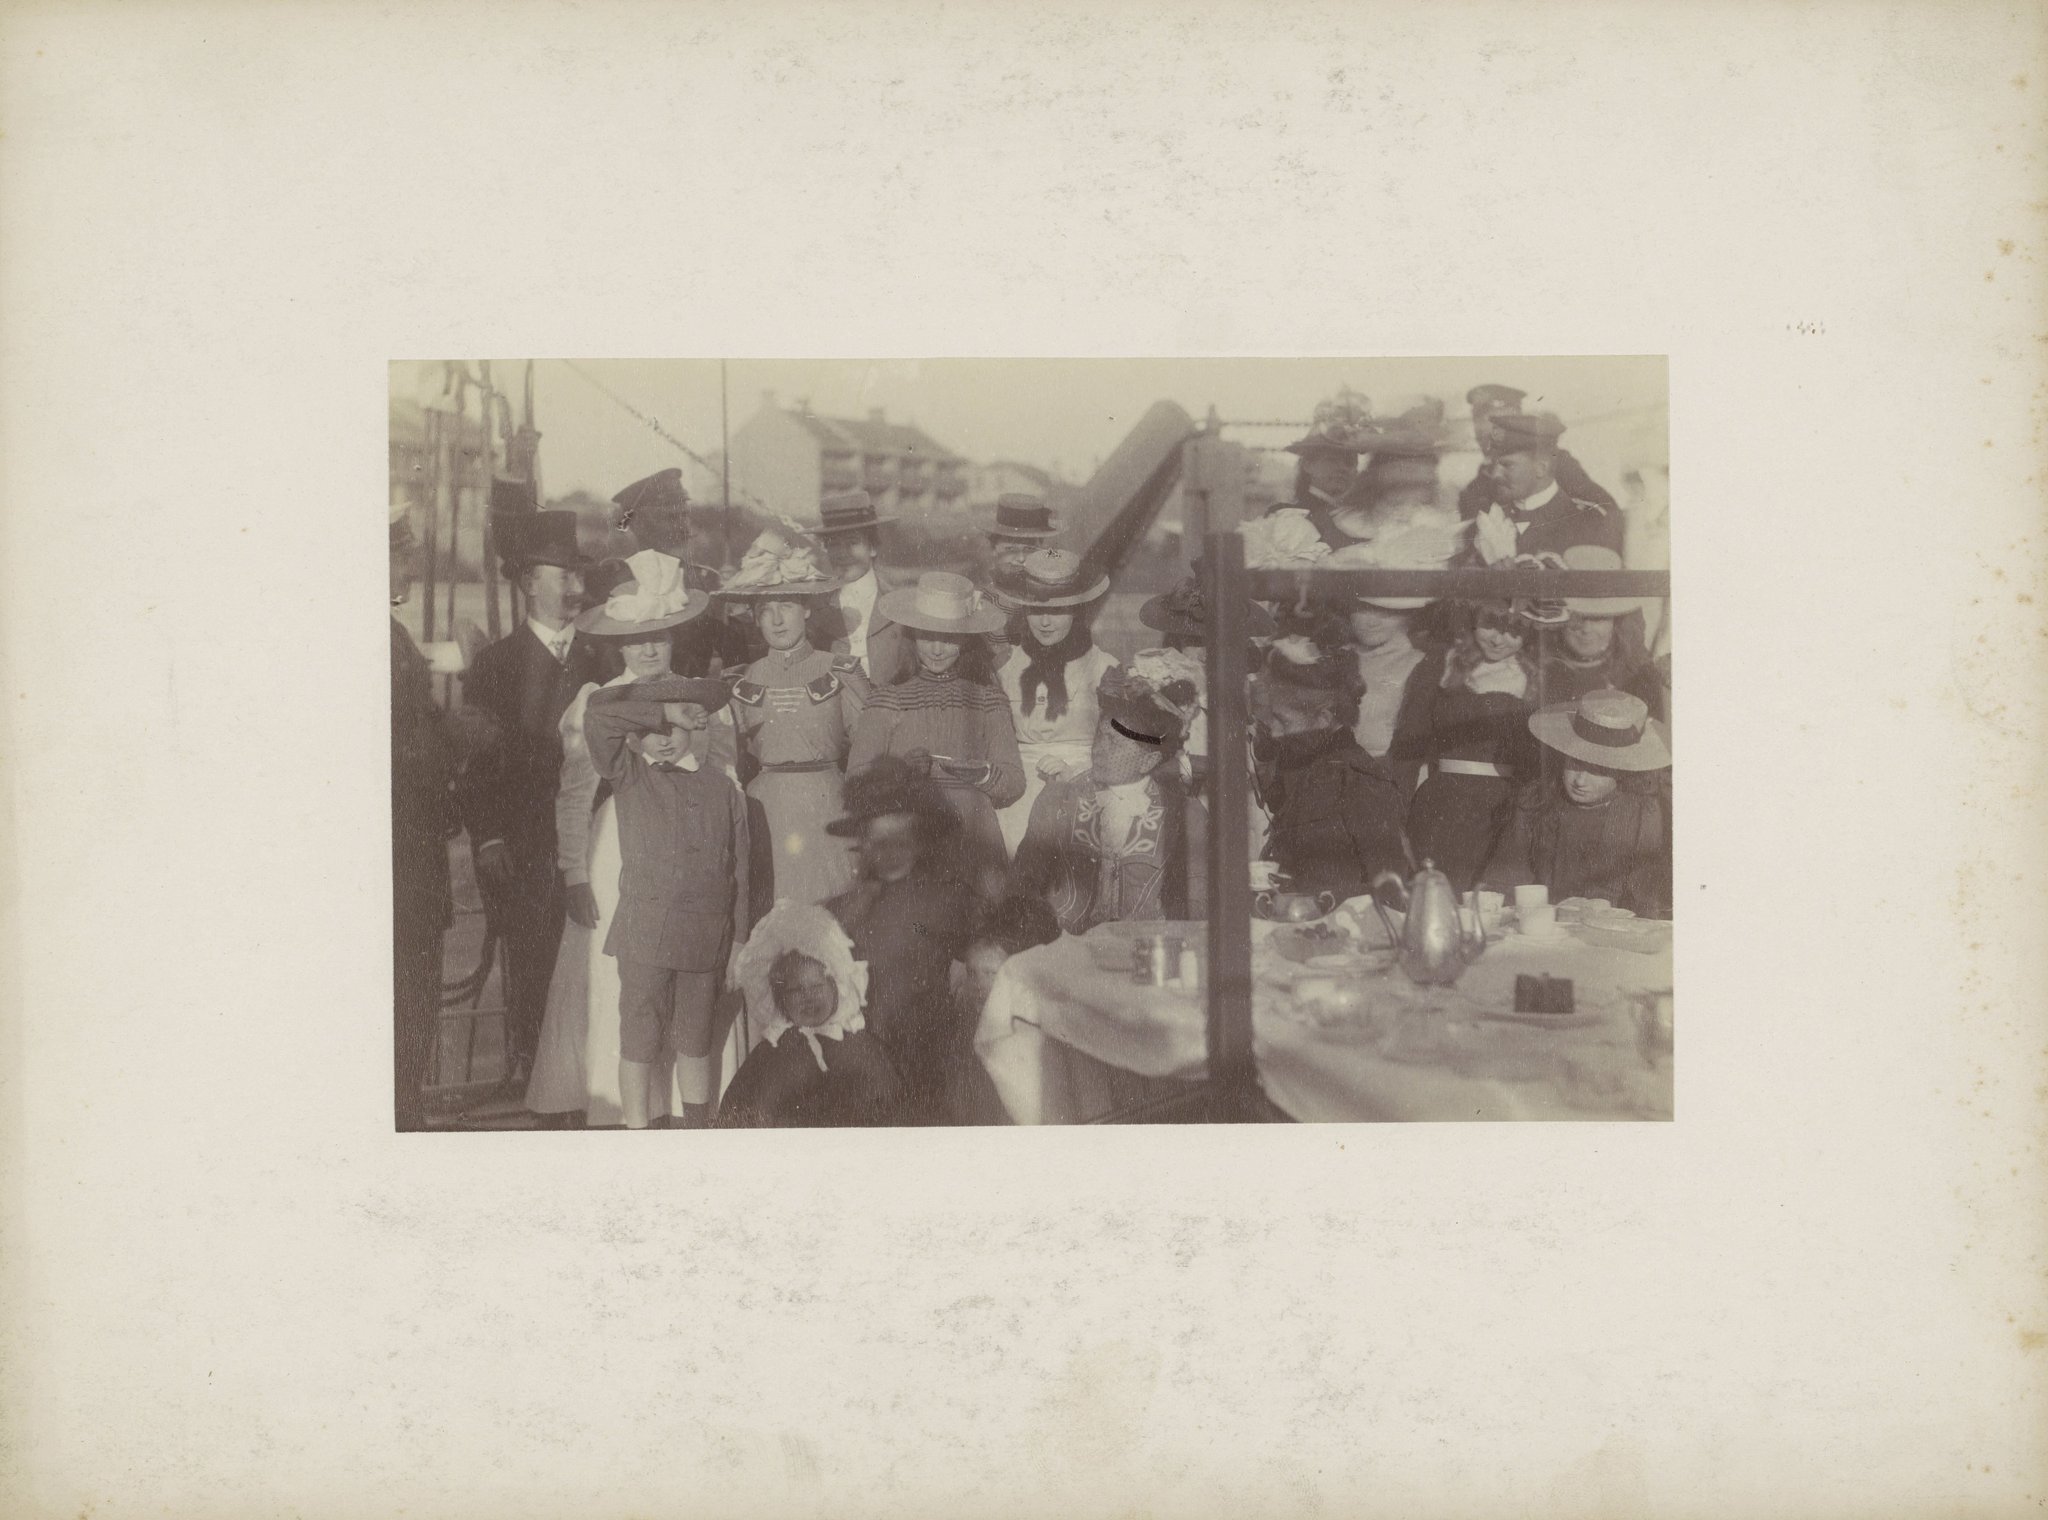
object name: photograph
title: Groepsportret van vrouwen, mannen en kinderen bij een tafel, vermoedelijk in Sydney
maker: Anonymous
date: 1890-1910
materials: cardboard, paper, photographic support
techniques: albumen print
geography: sydney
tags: adult woman, adult man, child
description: Onderdeel van Reisalbum met foto's van bezienswaardigheden in Sydney.